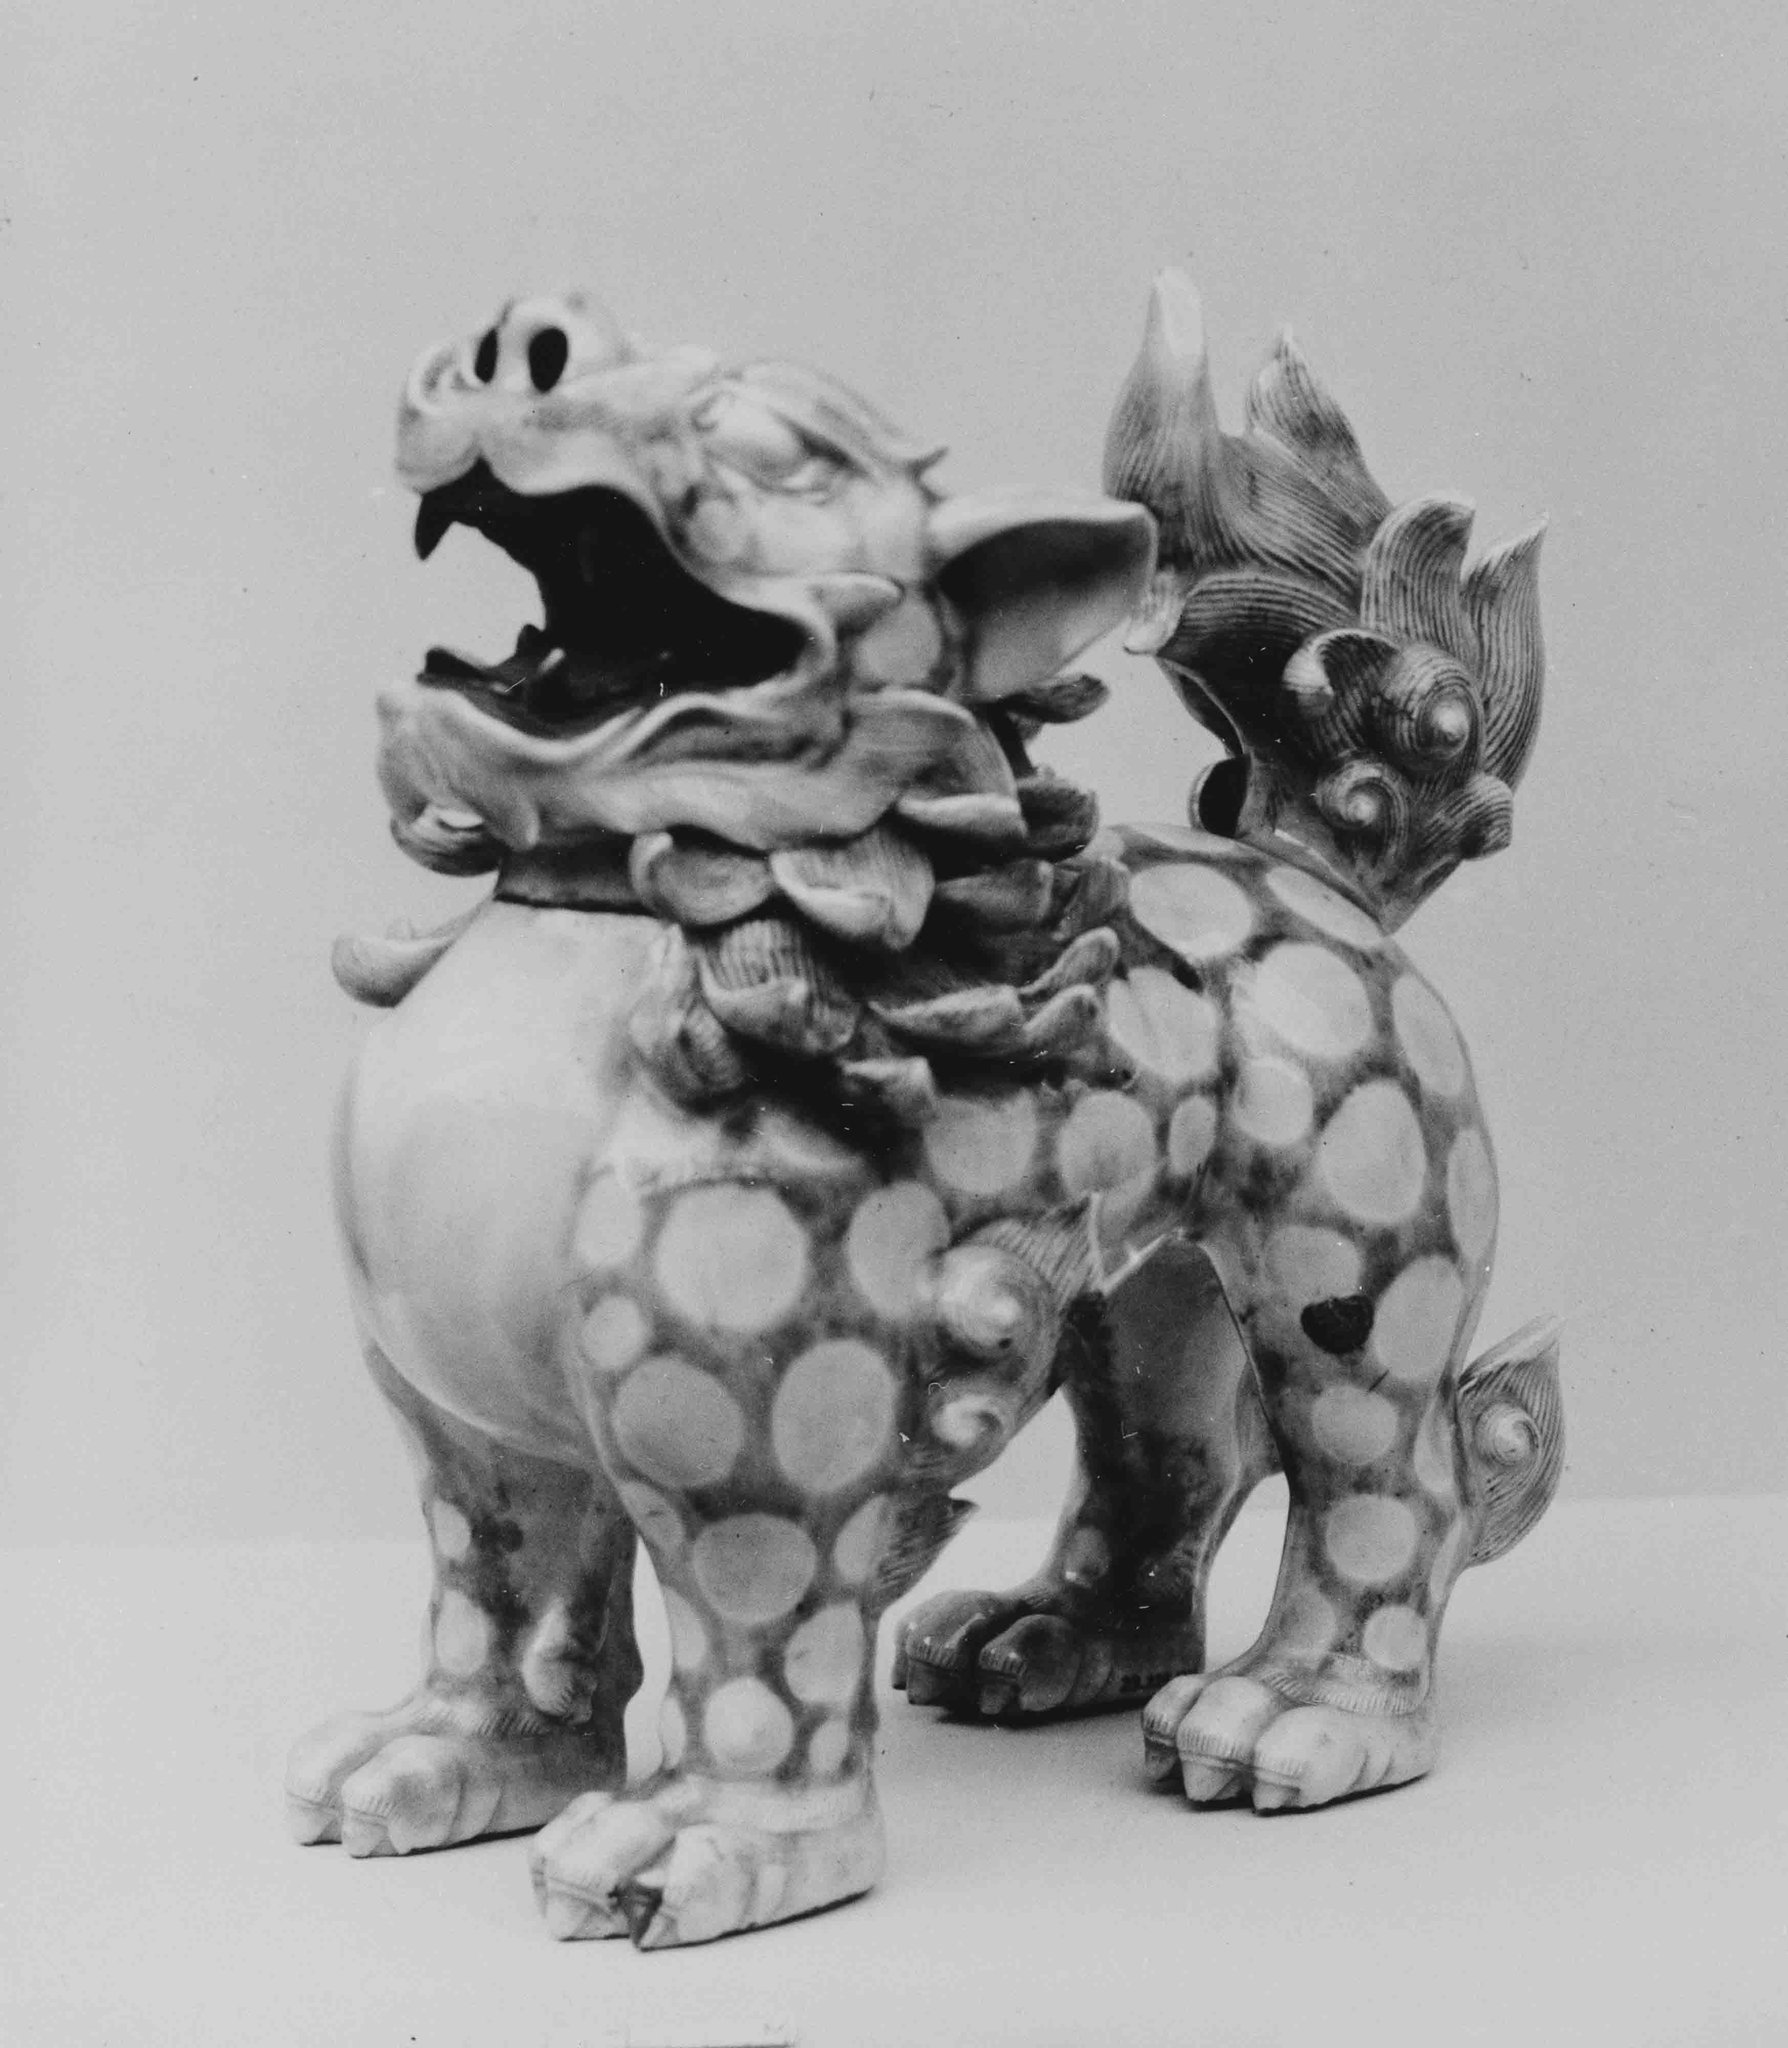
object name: censer and top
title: Censer and Top in form of a Shishi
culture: japanese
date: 1750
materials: enamel, porcelain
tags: animals,censers